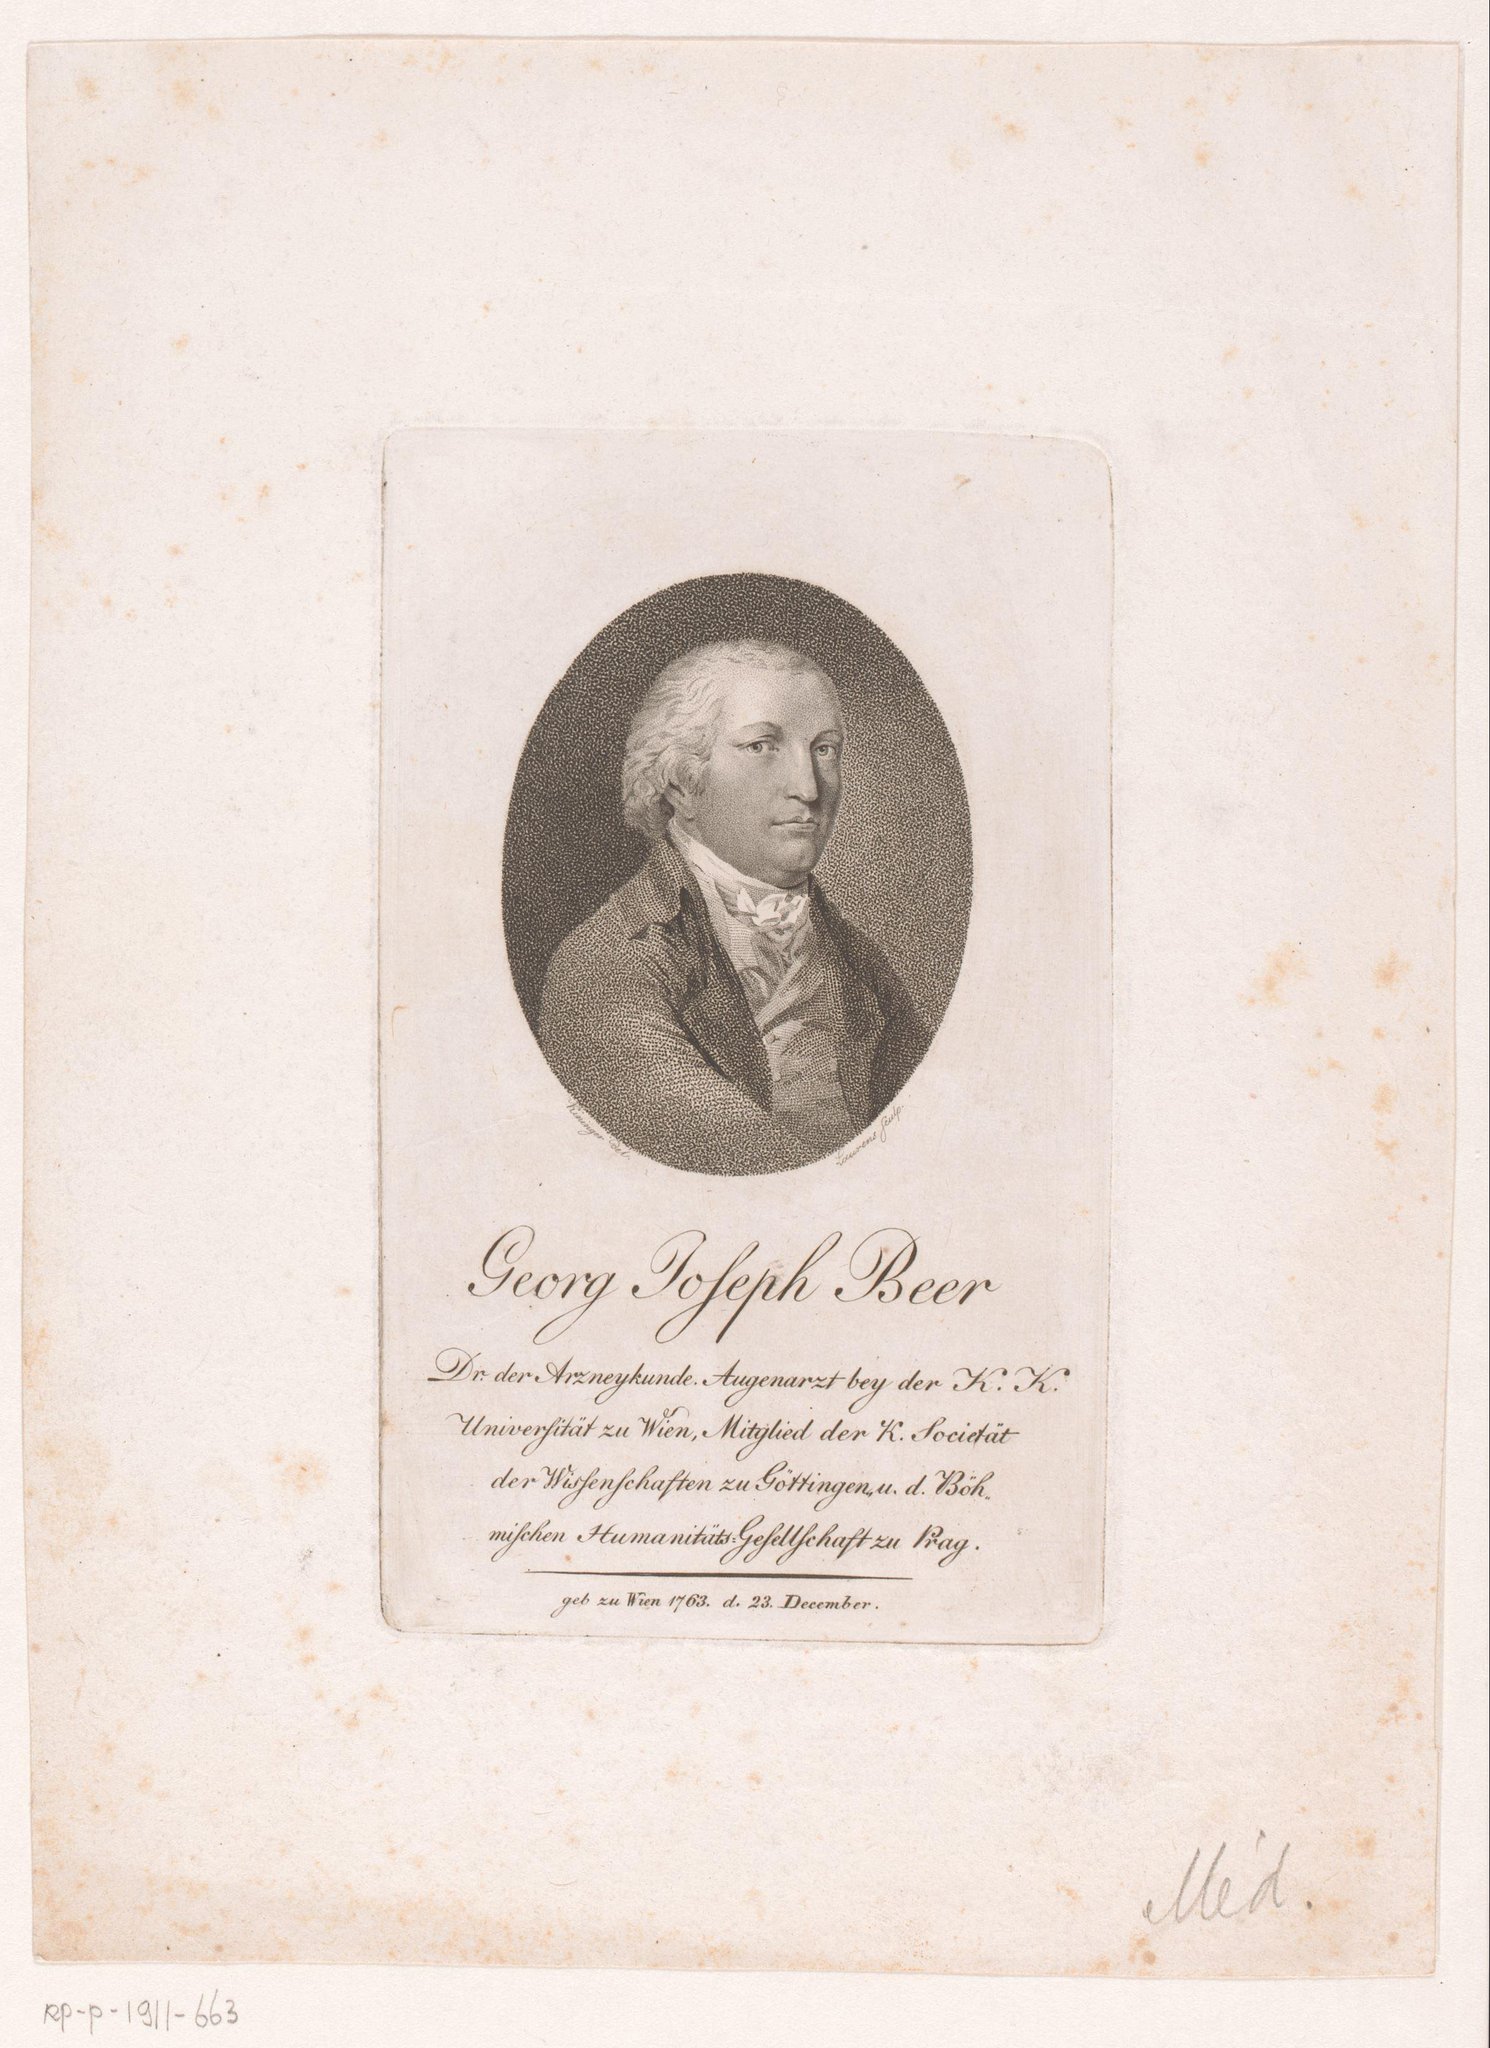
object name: print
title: Portret van Georg Joseph Beer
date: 1802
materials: paper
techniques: stippling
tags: vienna, further education (+ portrait of teacher, professor), historical persons, physician, doctor (+ portrait of scholar, scientist)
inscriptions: collector's mark: Lugt 2228